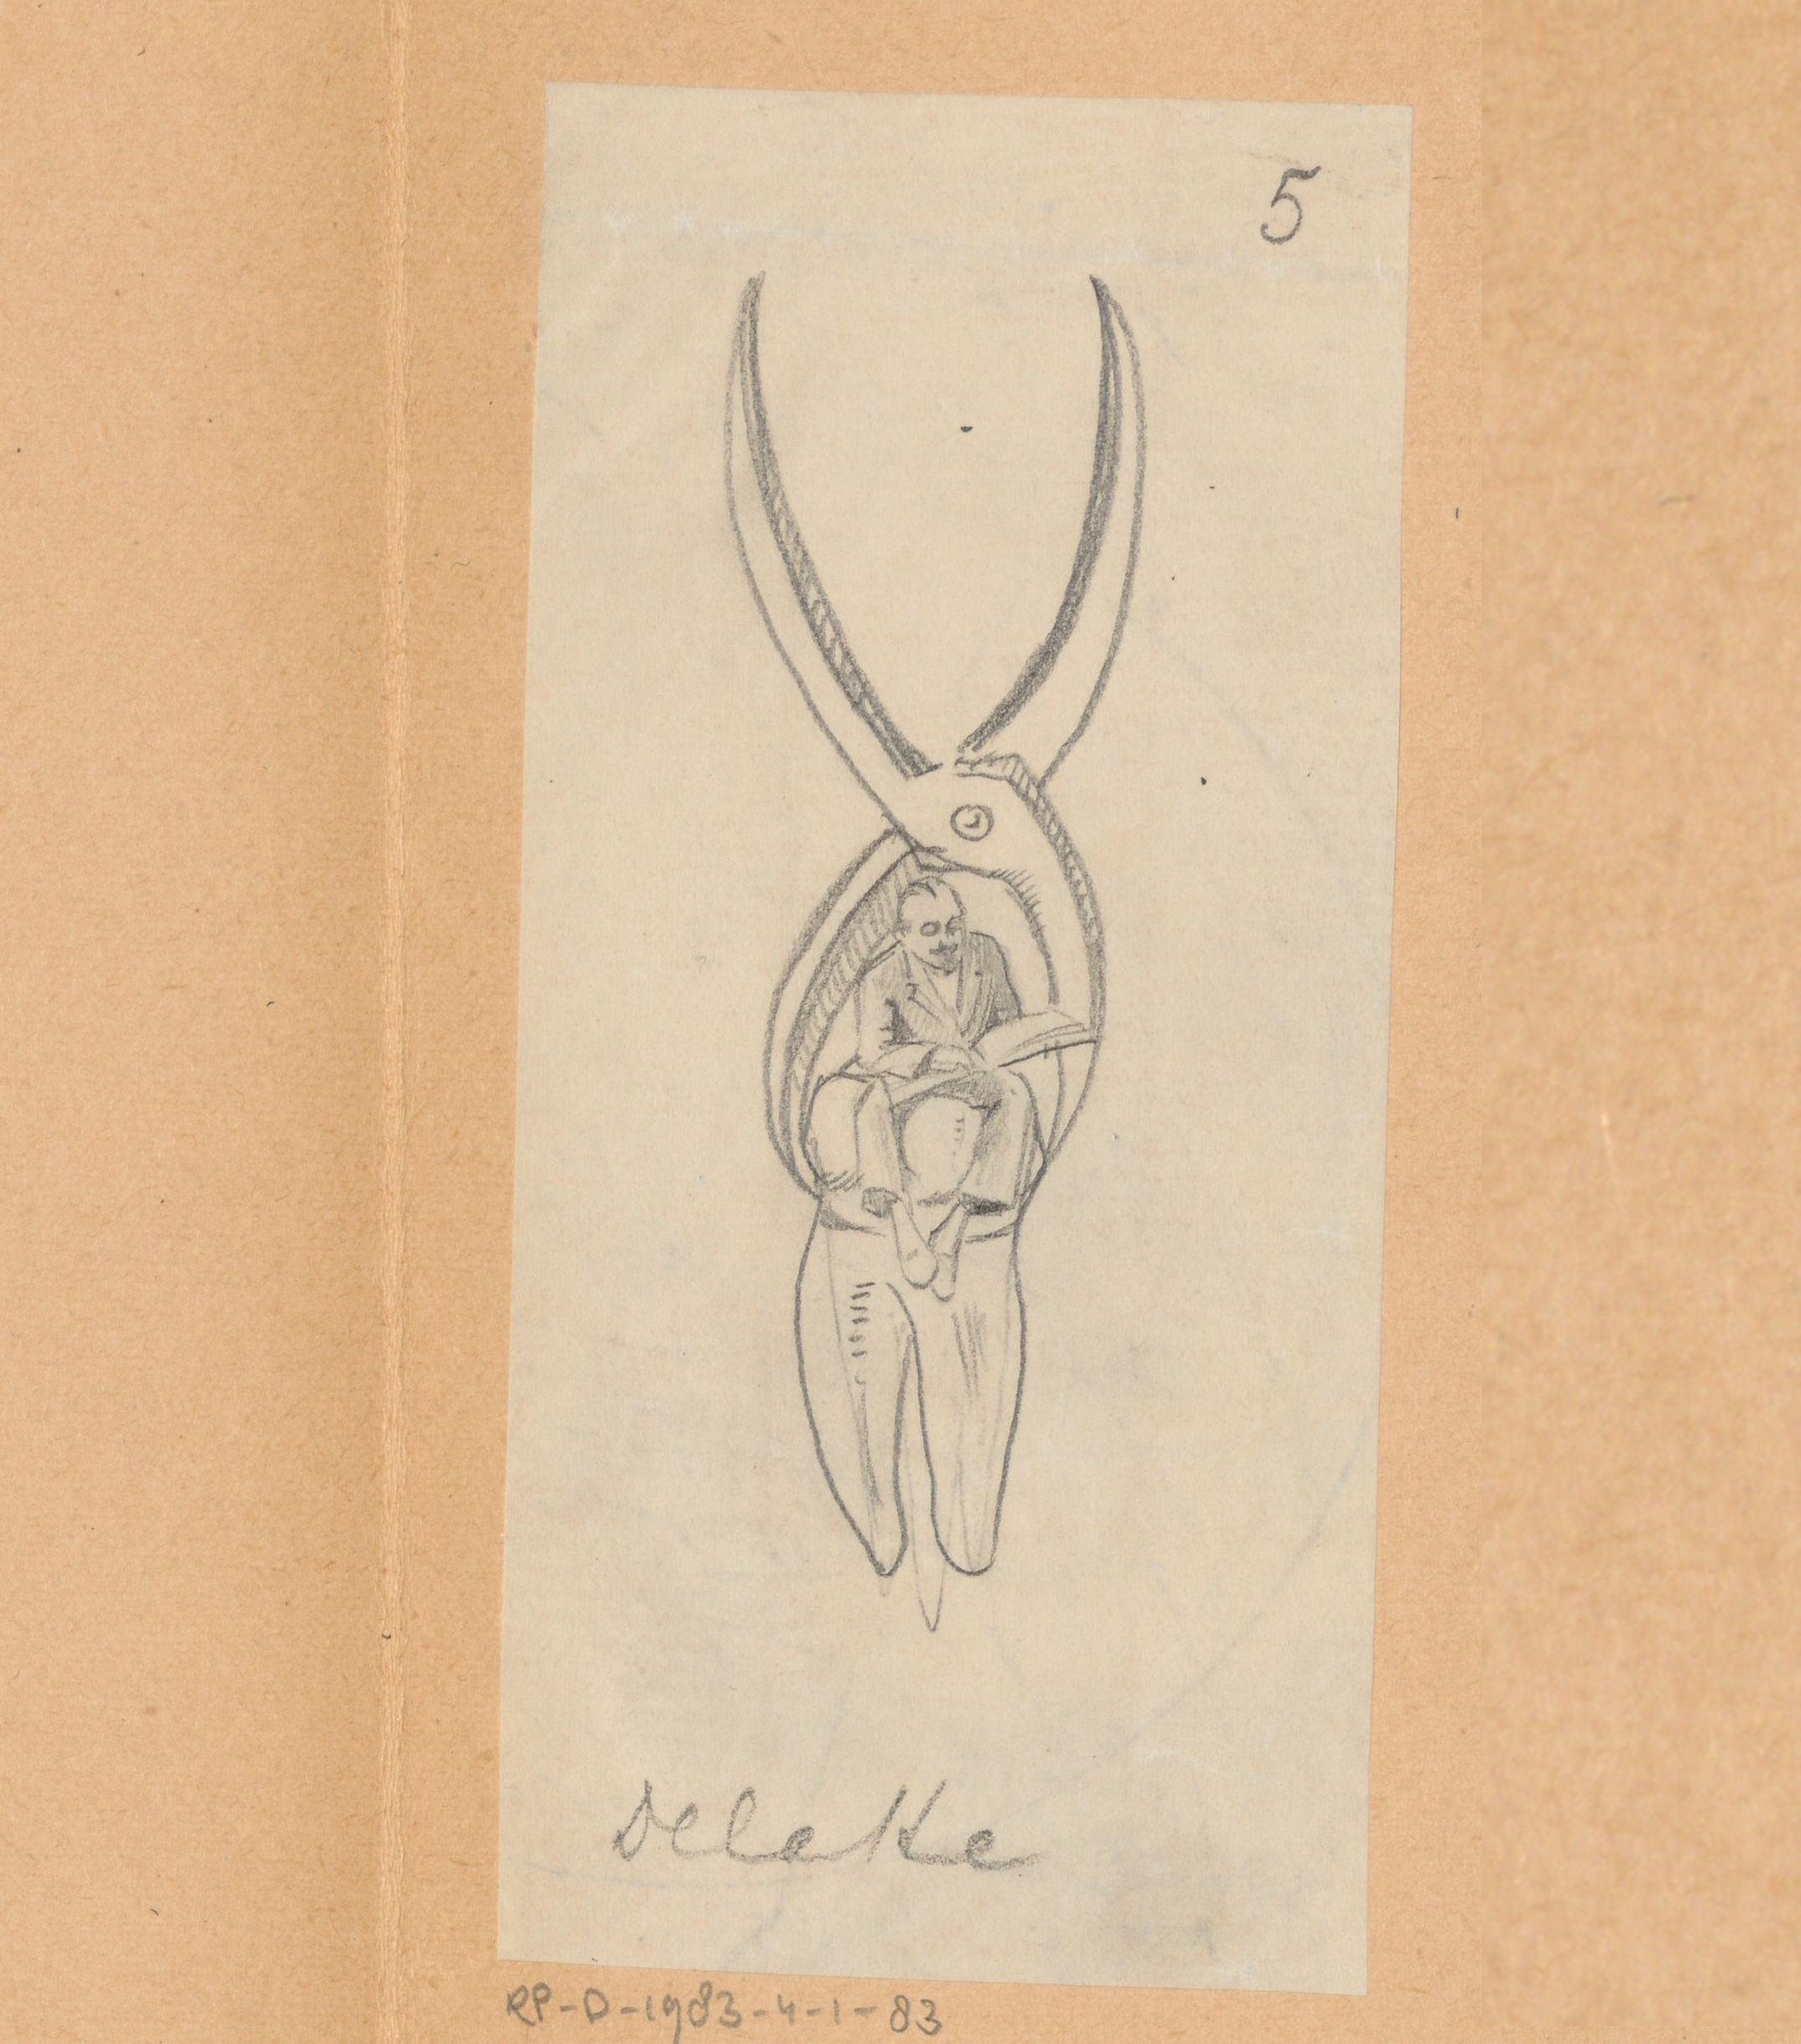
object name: design drawing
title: Ex libris dr. Lucien Delatte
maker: otto verhagen (i)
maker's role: draughtsman, print maker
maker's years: 1885-1951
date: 1933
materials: paper, pencil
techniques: drawing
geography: netherlands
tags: crocodiles, birds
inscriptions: inscription: ‘à executer en dessin à la plume’, inscription: ‘3.’